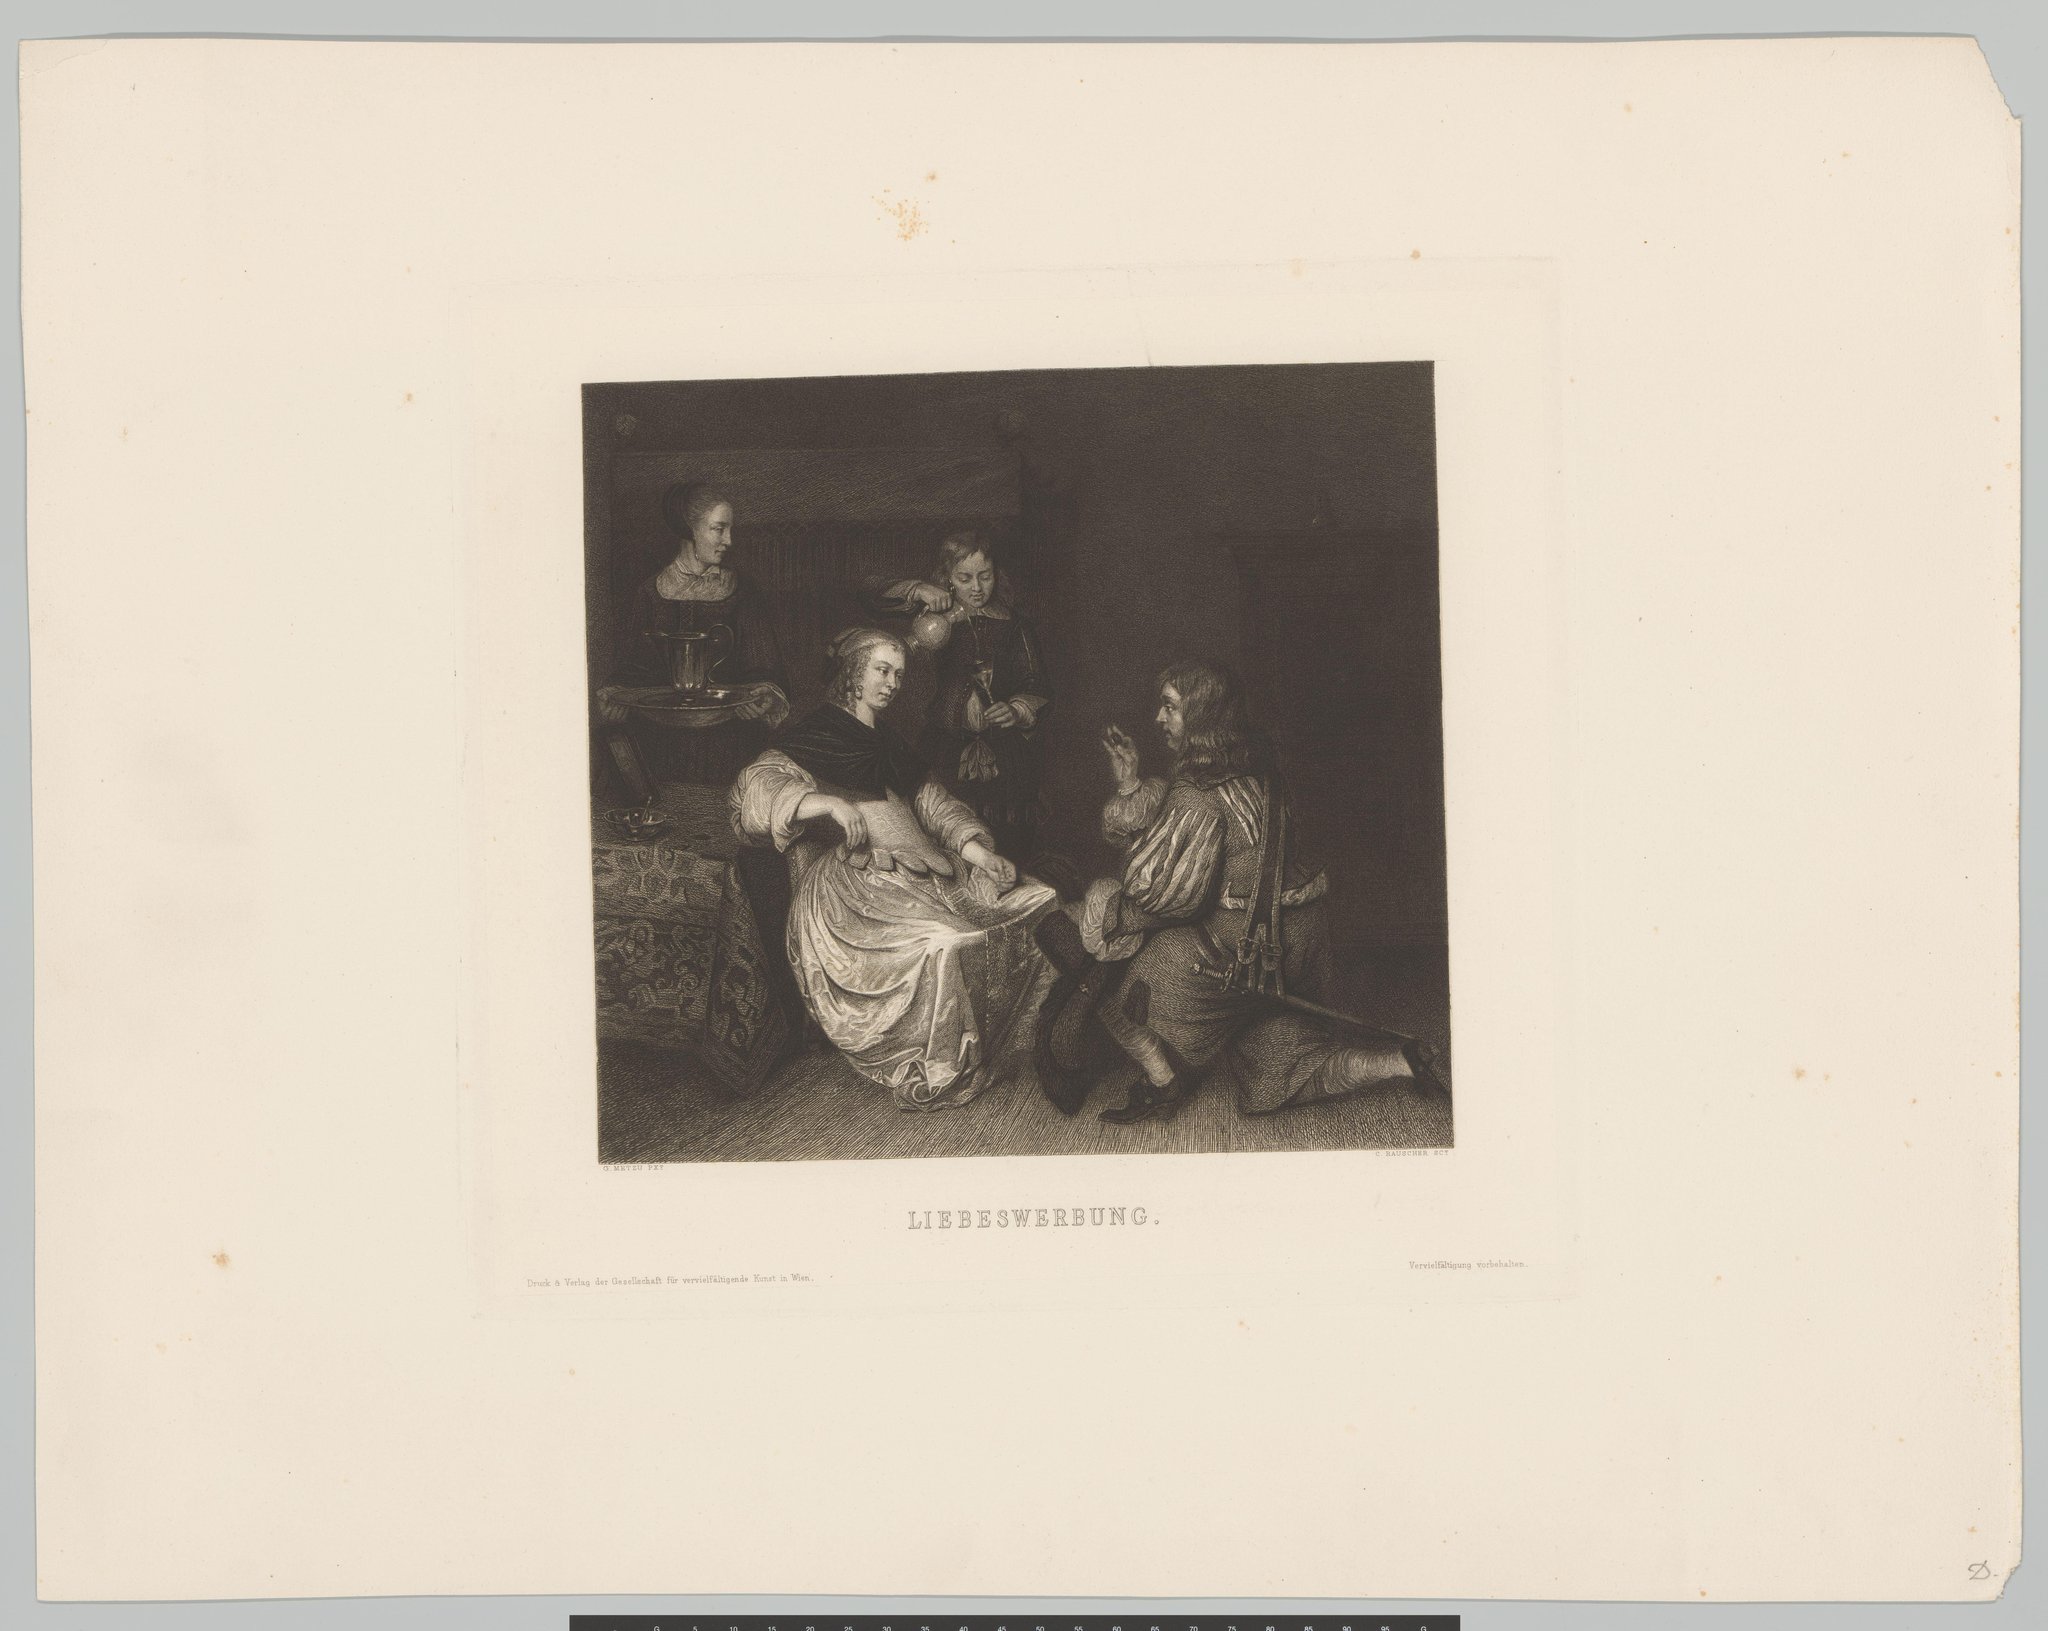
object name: print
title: Liebeswerbung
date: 1851-1899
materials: paper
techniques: engraving, etching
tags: proposal, declaration of love